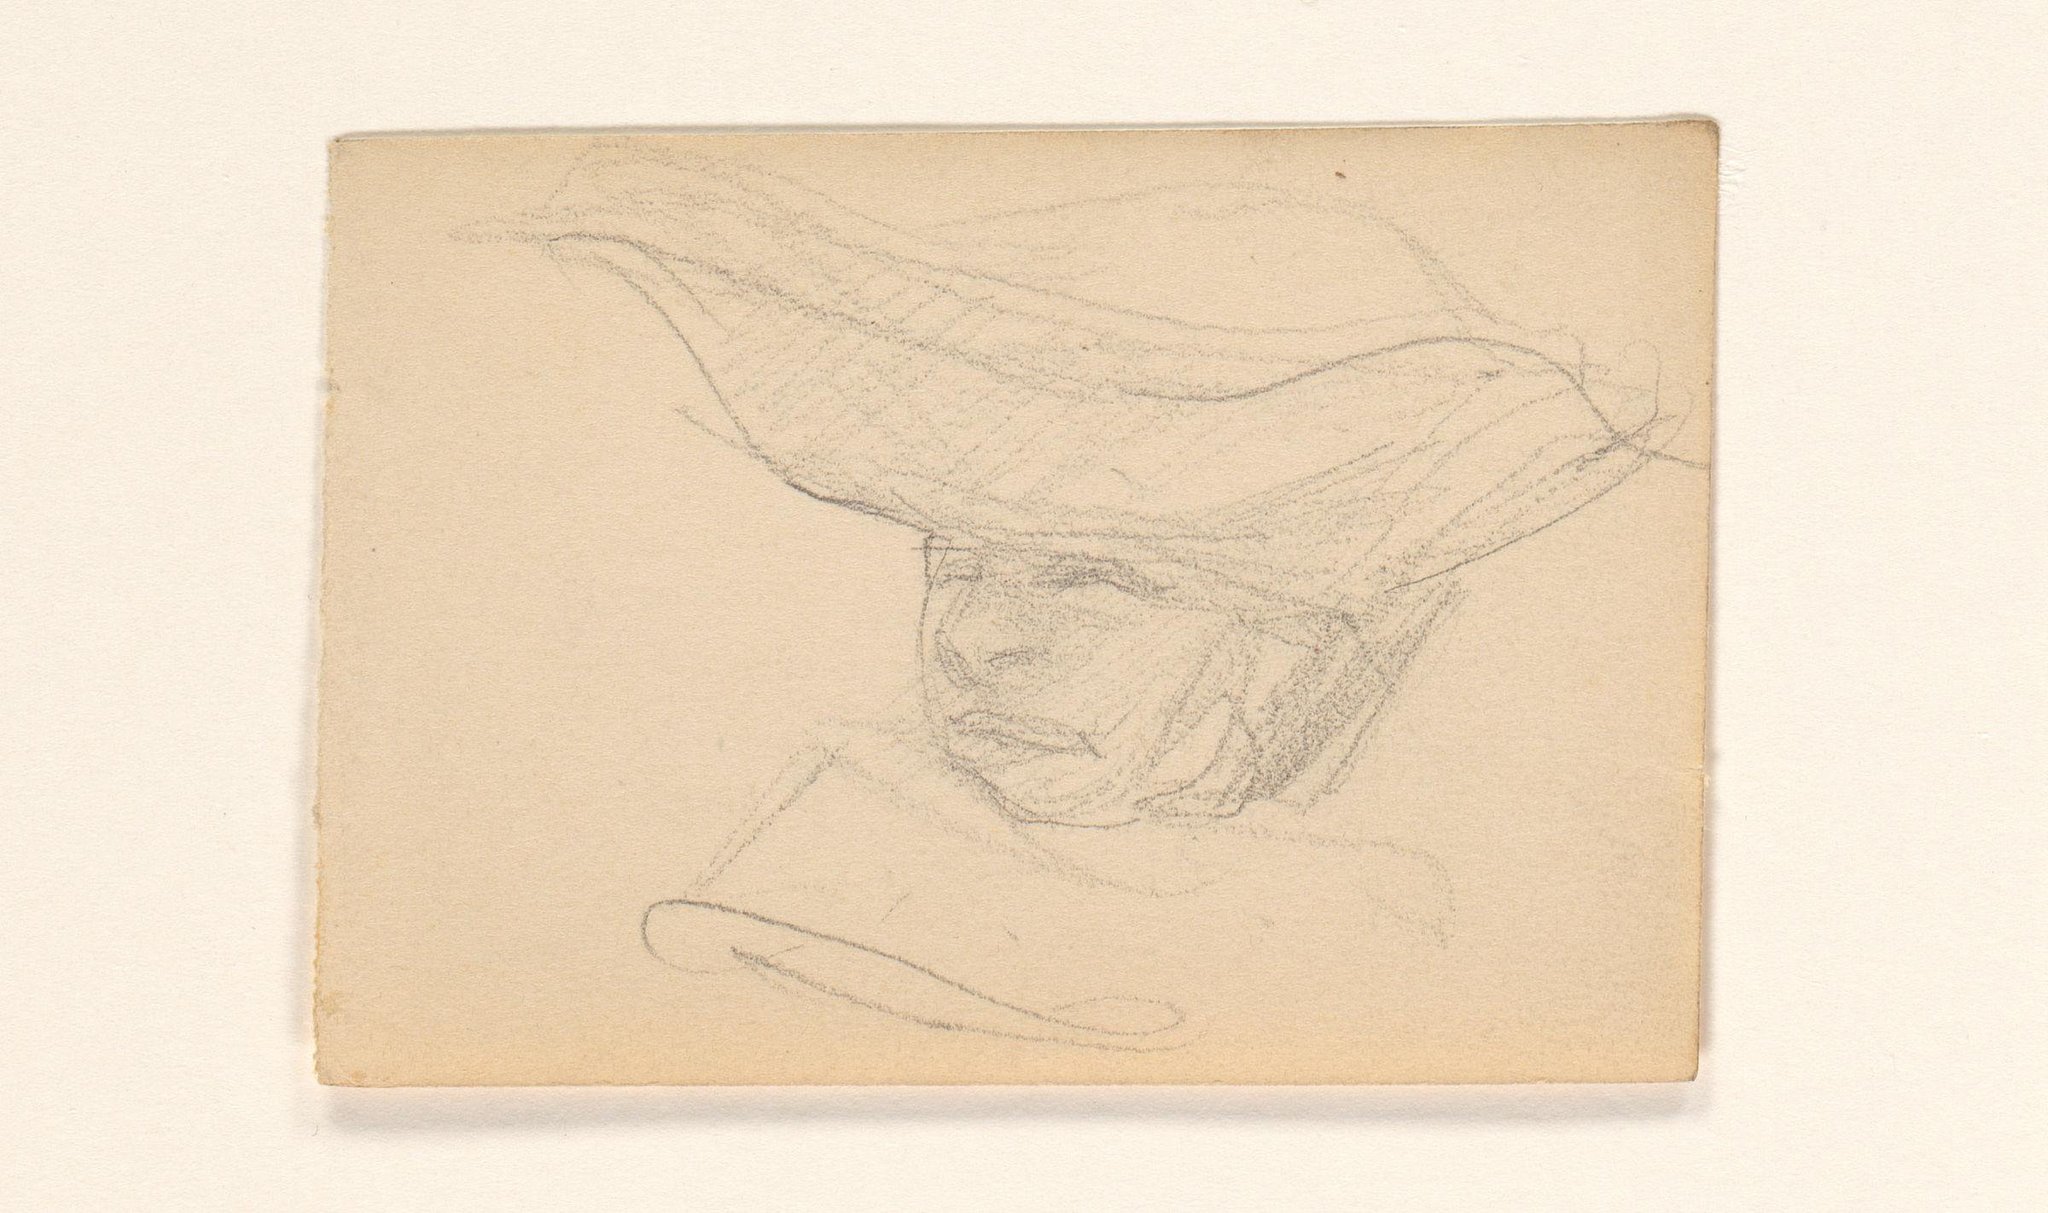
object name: drawing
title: Kind met een hoed op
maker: august allebé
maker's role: draughtsman, print maker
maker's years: 1838-1927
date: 1859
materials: paper, pencil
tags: the (nude) human figure; 'corpo humano' (ripa), piece of sculpture, reproduction of a piece of sculpture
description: Studie van een beeldhouwwerk in het Louvre.